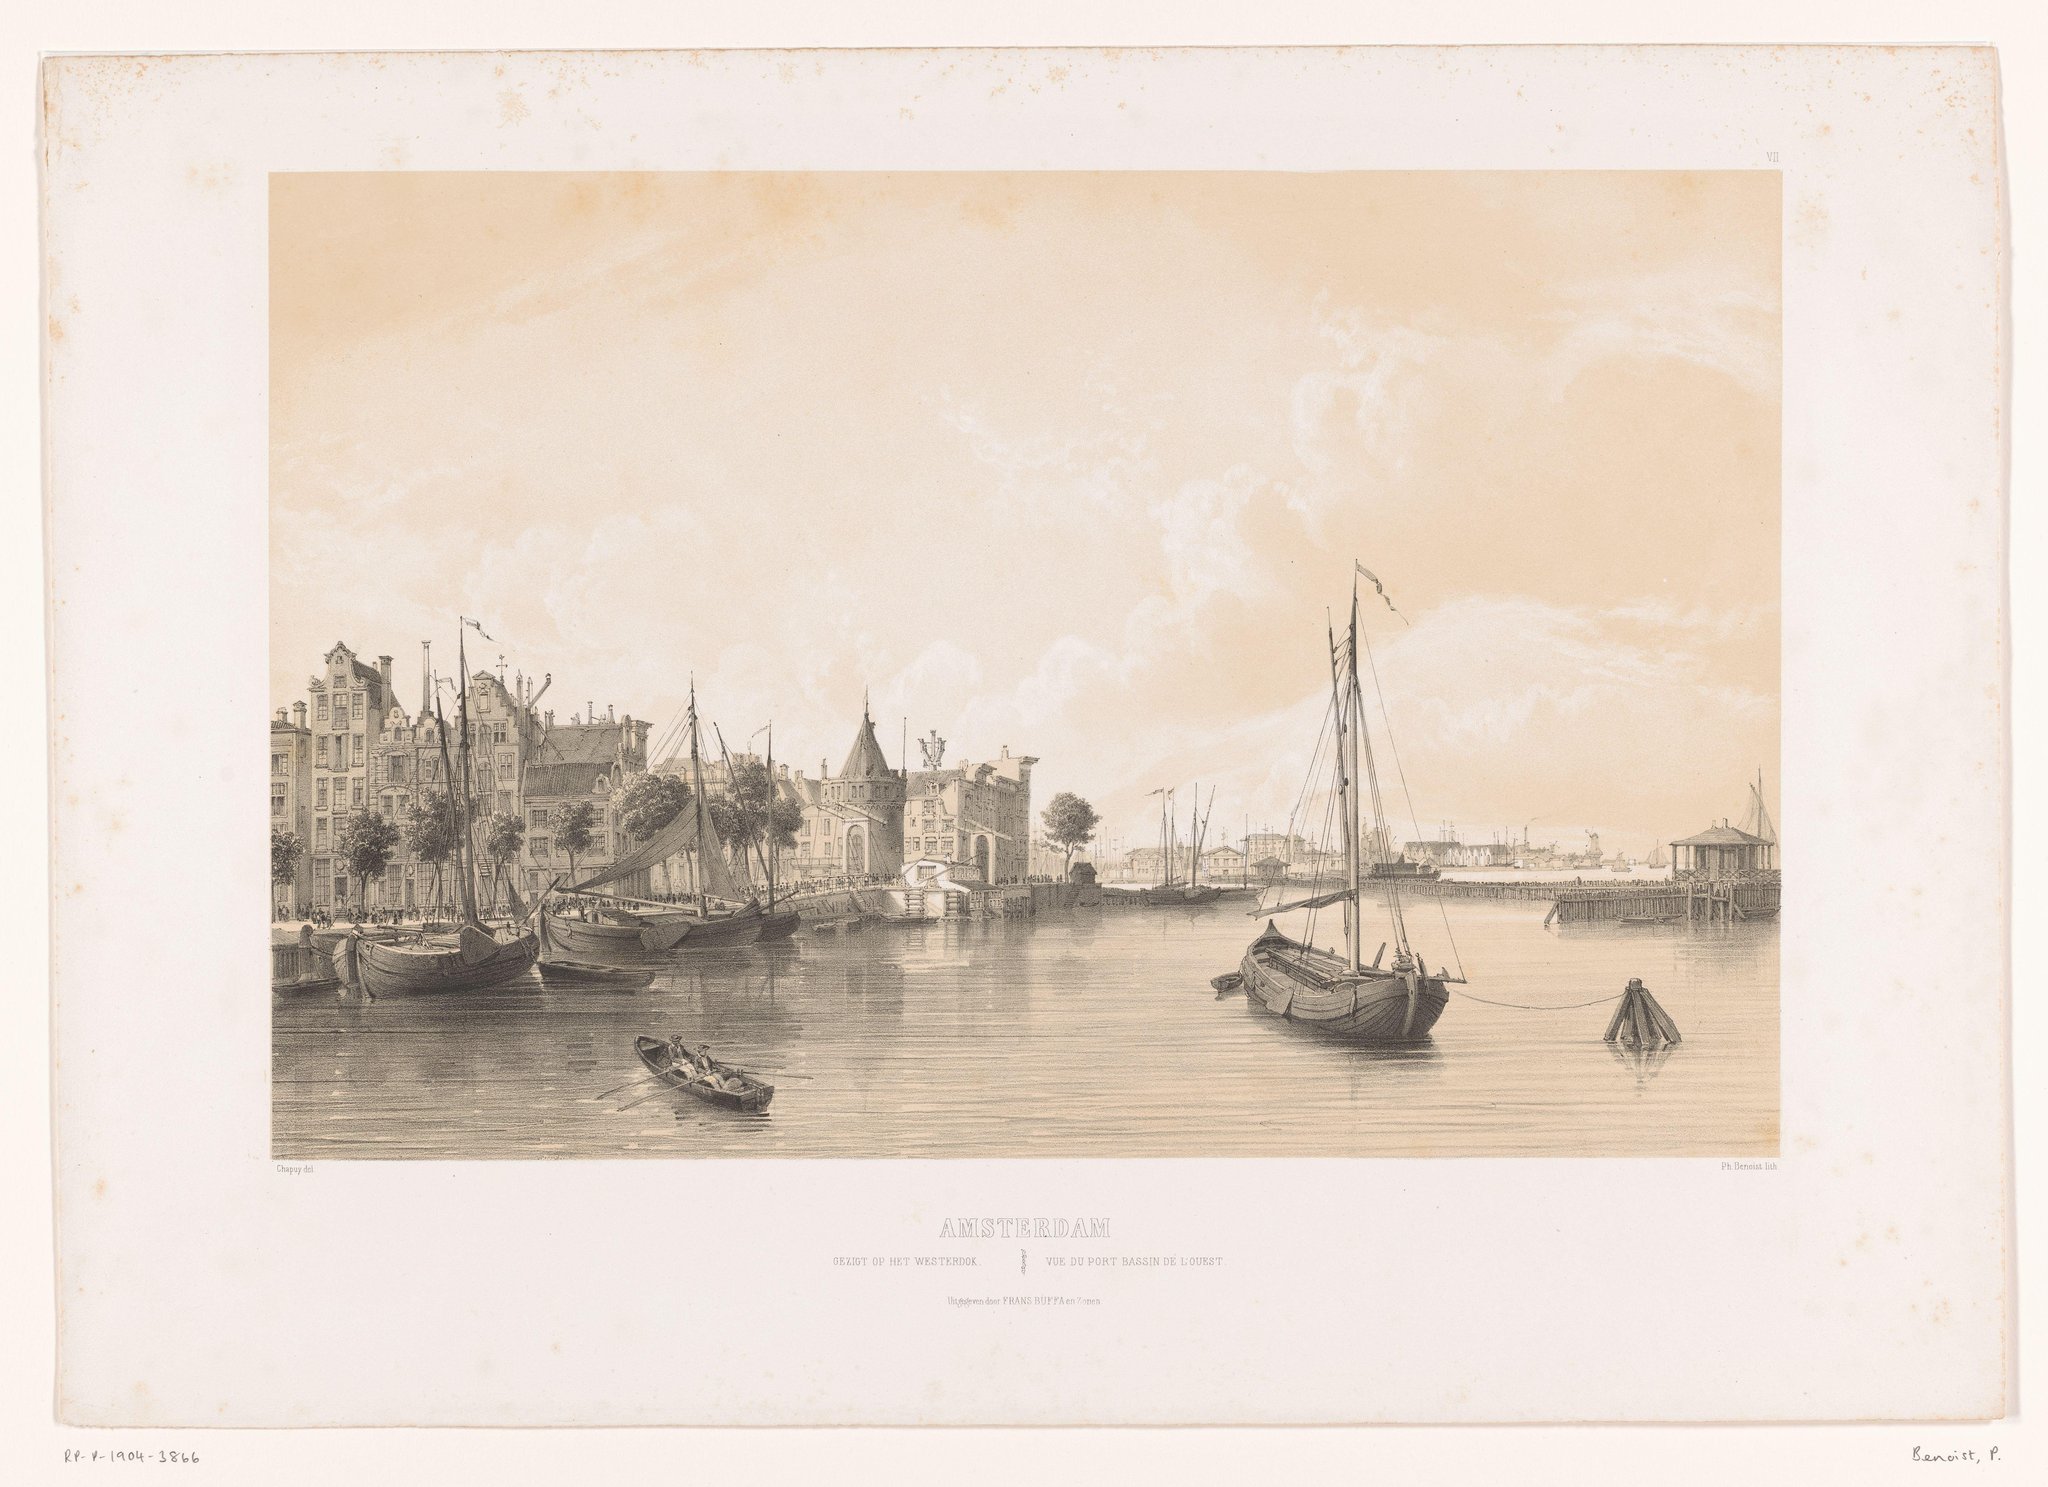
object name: print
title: Gezigt op het Westerdok / Vue du Port Bassin de l'Ouest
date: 1851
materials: paper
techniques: tone lithography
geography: amsterdam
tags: ships (in general), canals, waters (in city) (+ city(-scape) with figures, staffage)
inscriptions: collector's mark: Lugt 2228a